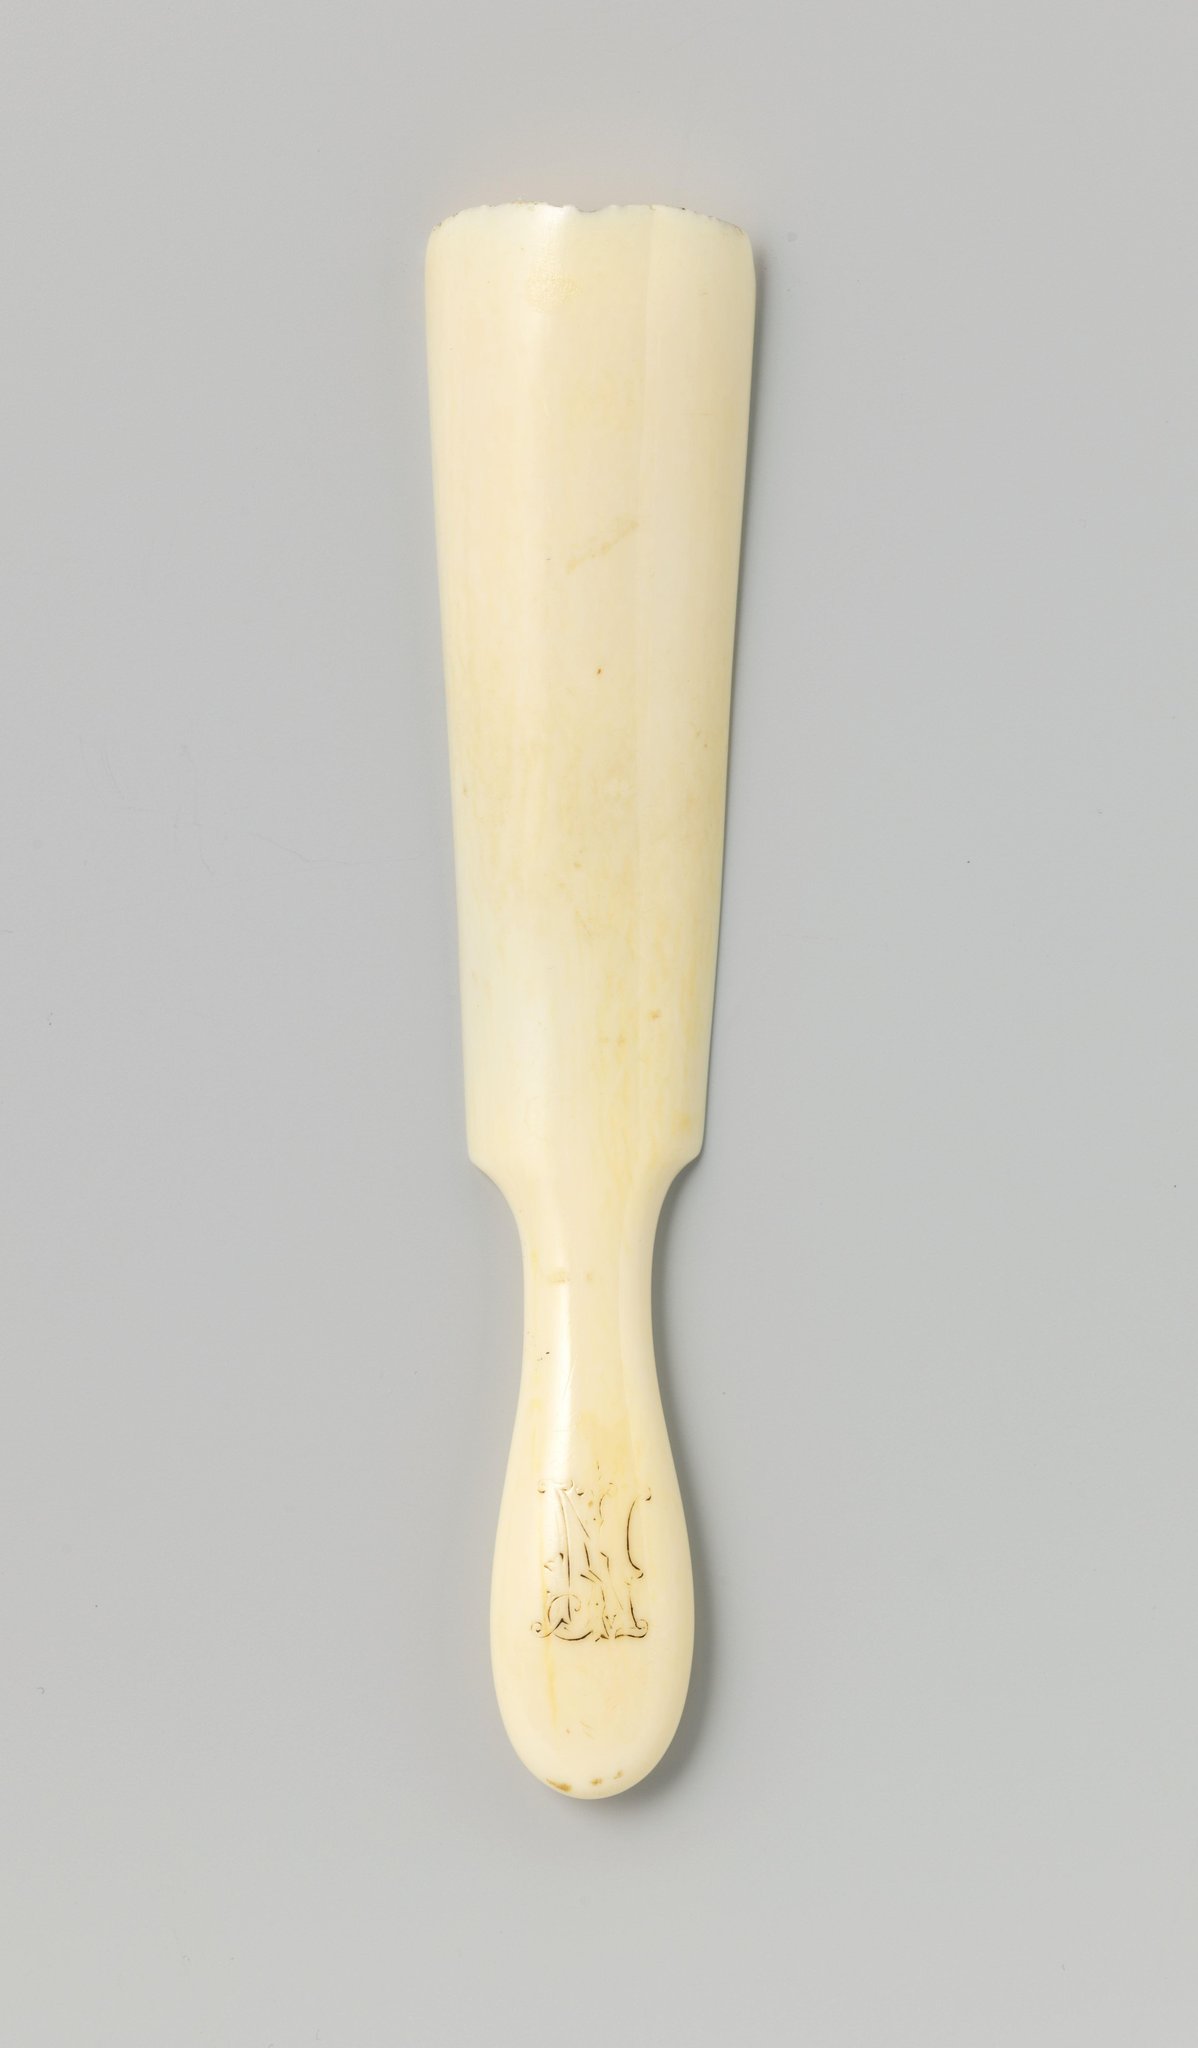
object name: trekker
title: Schoentrekker van ivoor met monogram JVN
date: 1910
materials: ivory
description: Schoentrekker van ivoor met het monogram JVN, in geborduurd zakje.